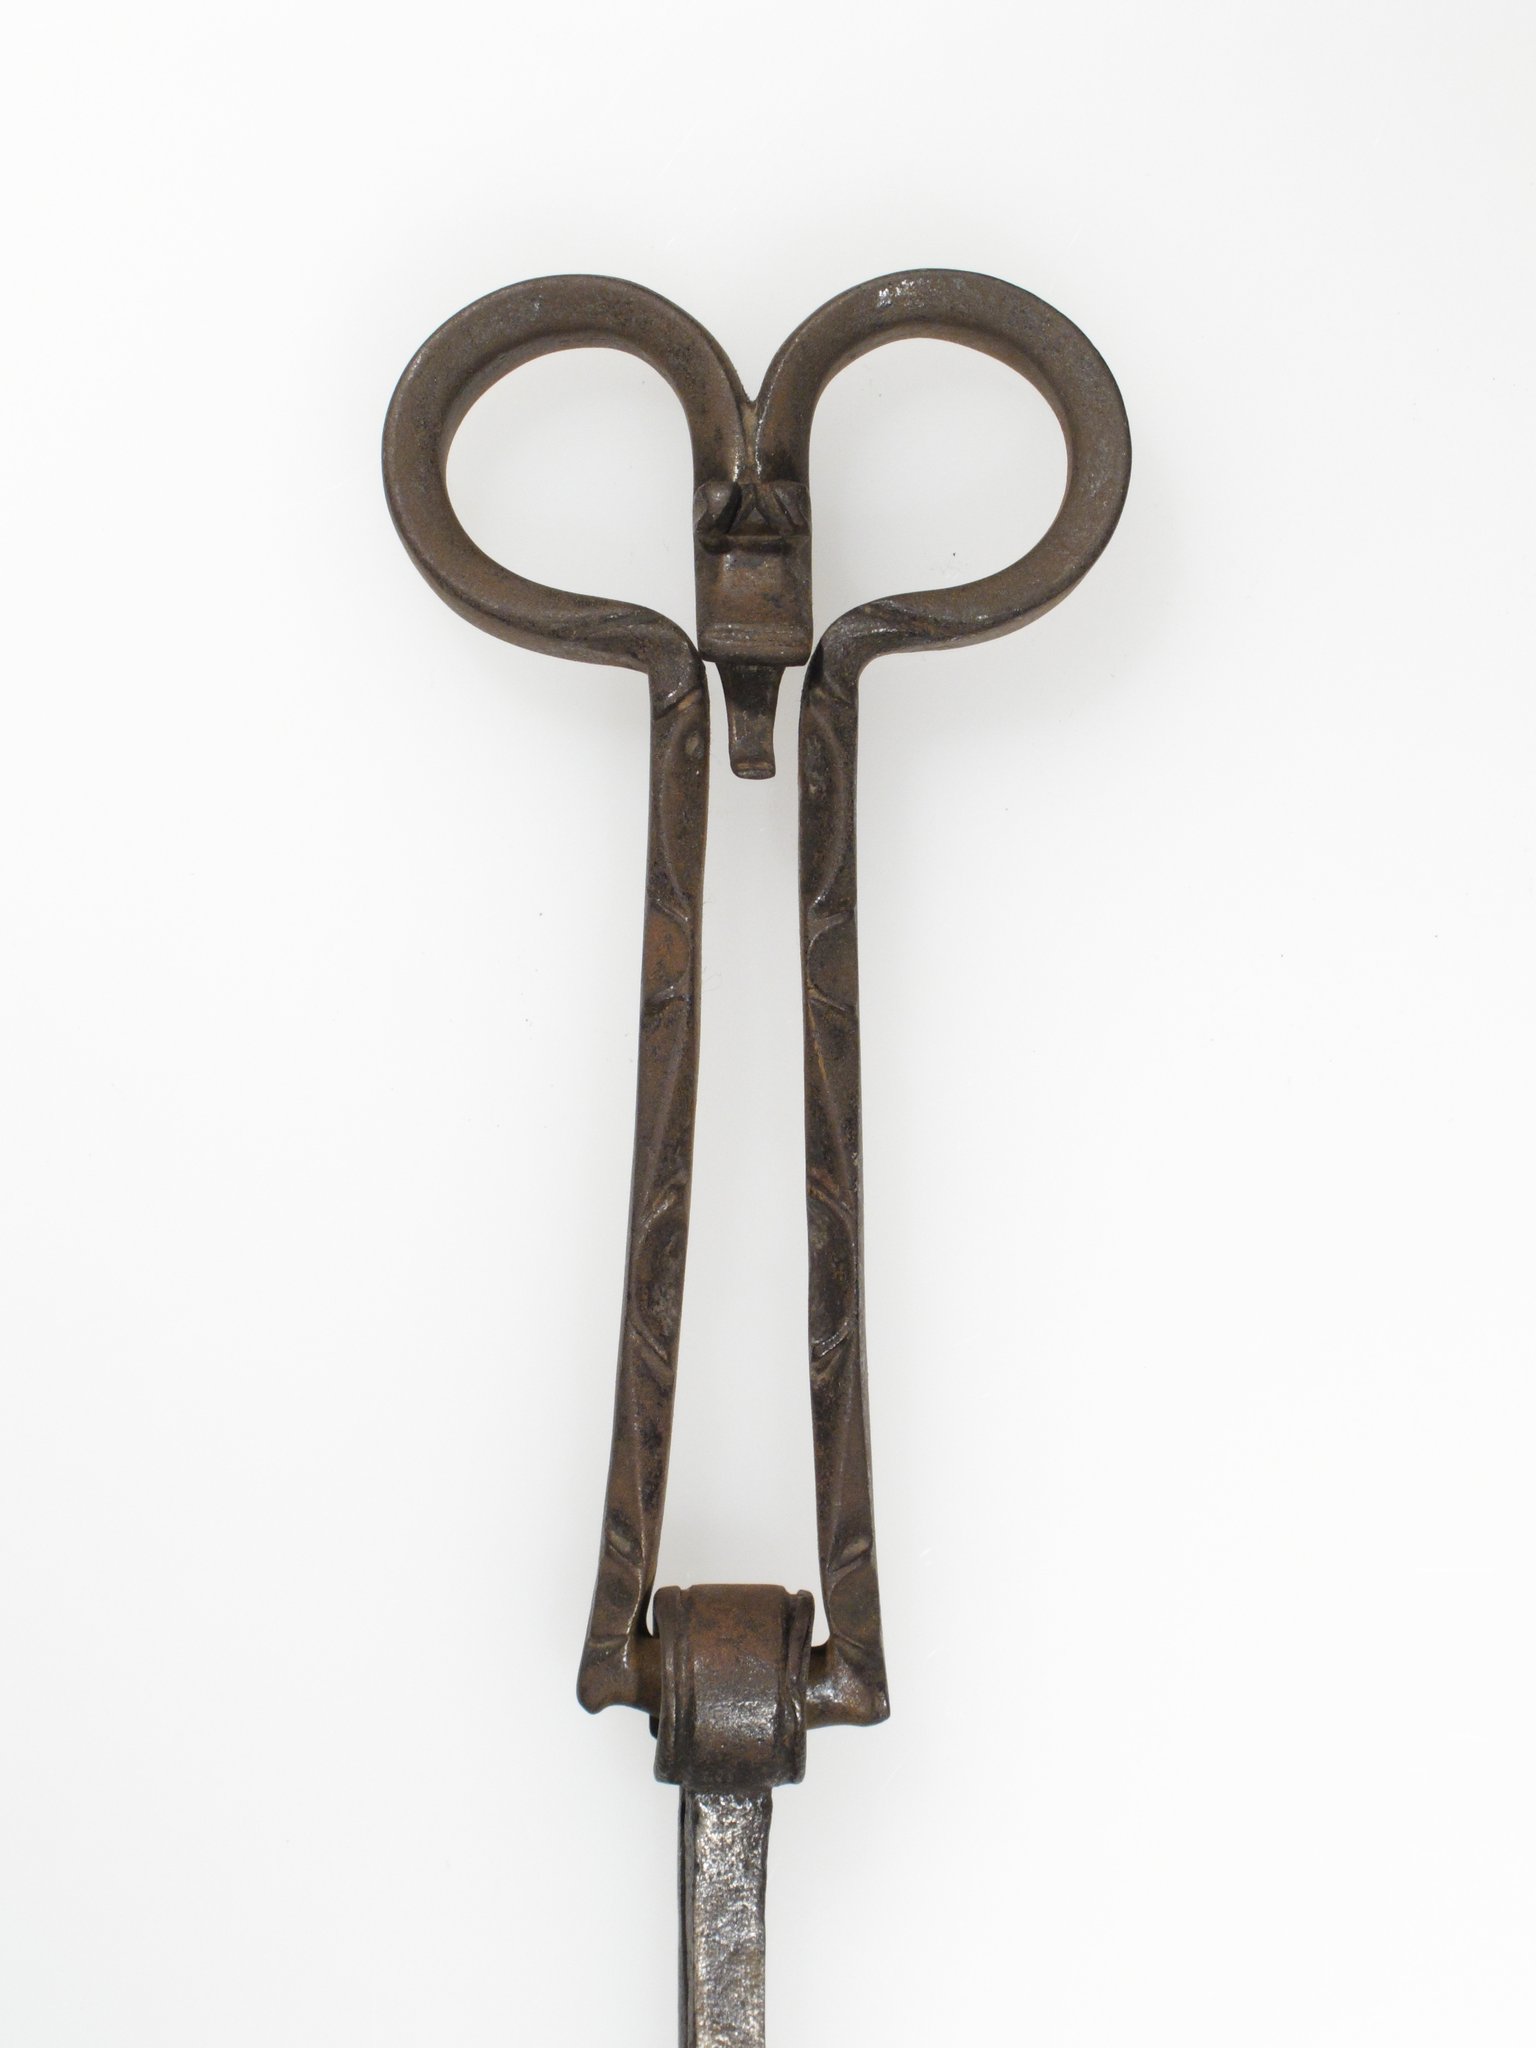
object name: handle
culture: european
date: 1401-1600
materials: iron